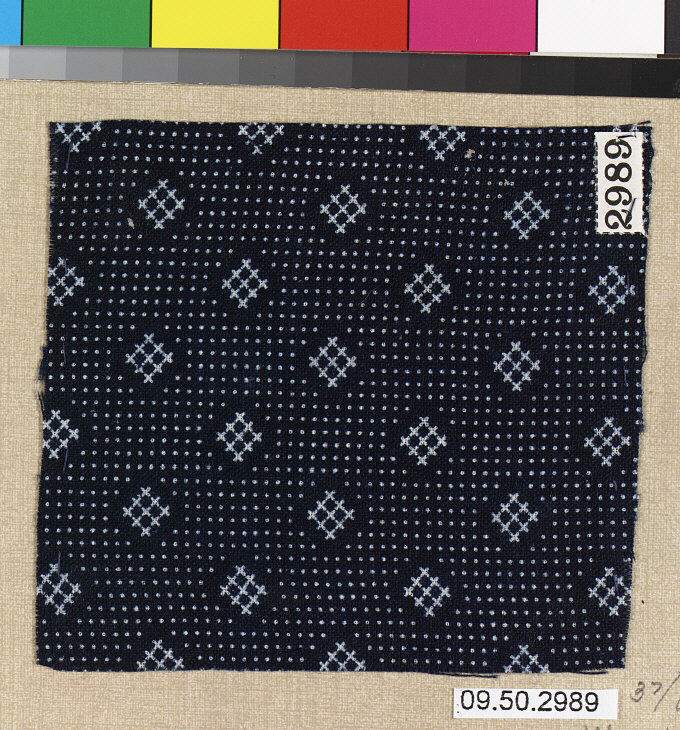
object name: piece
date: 1801-1900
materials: cotton